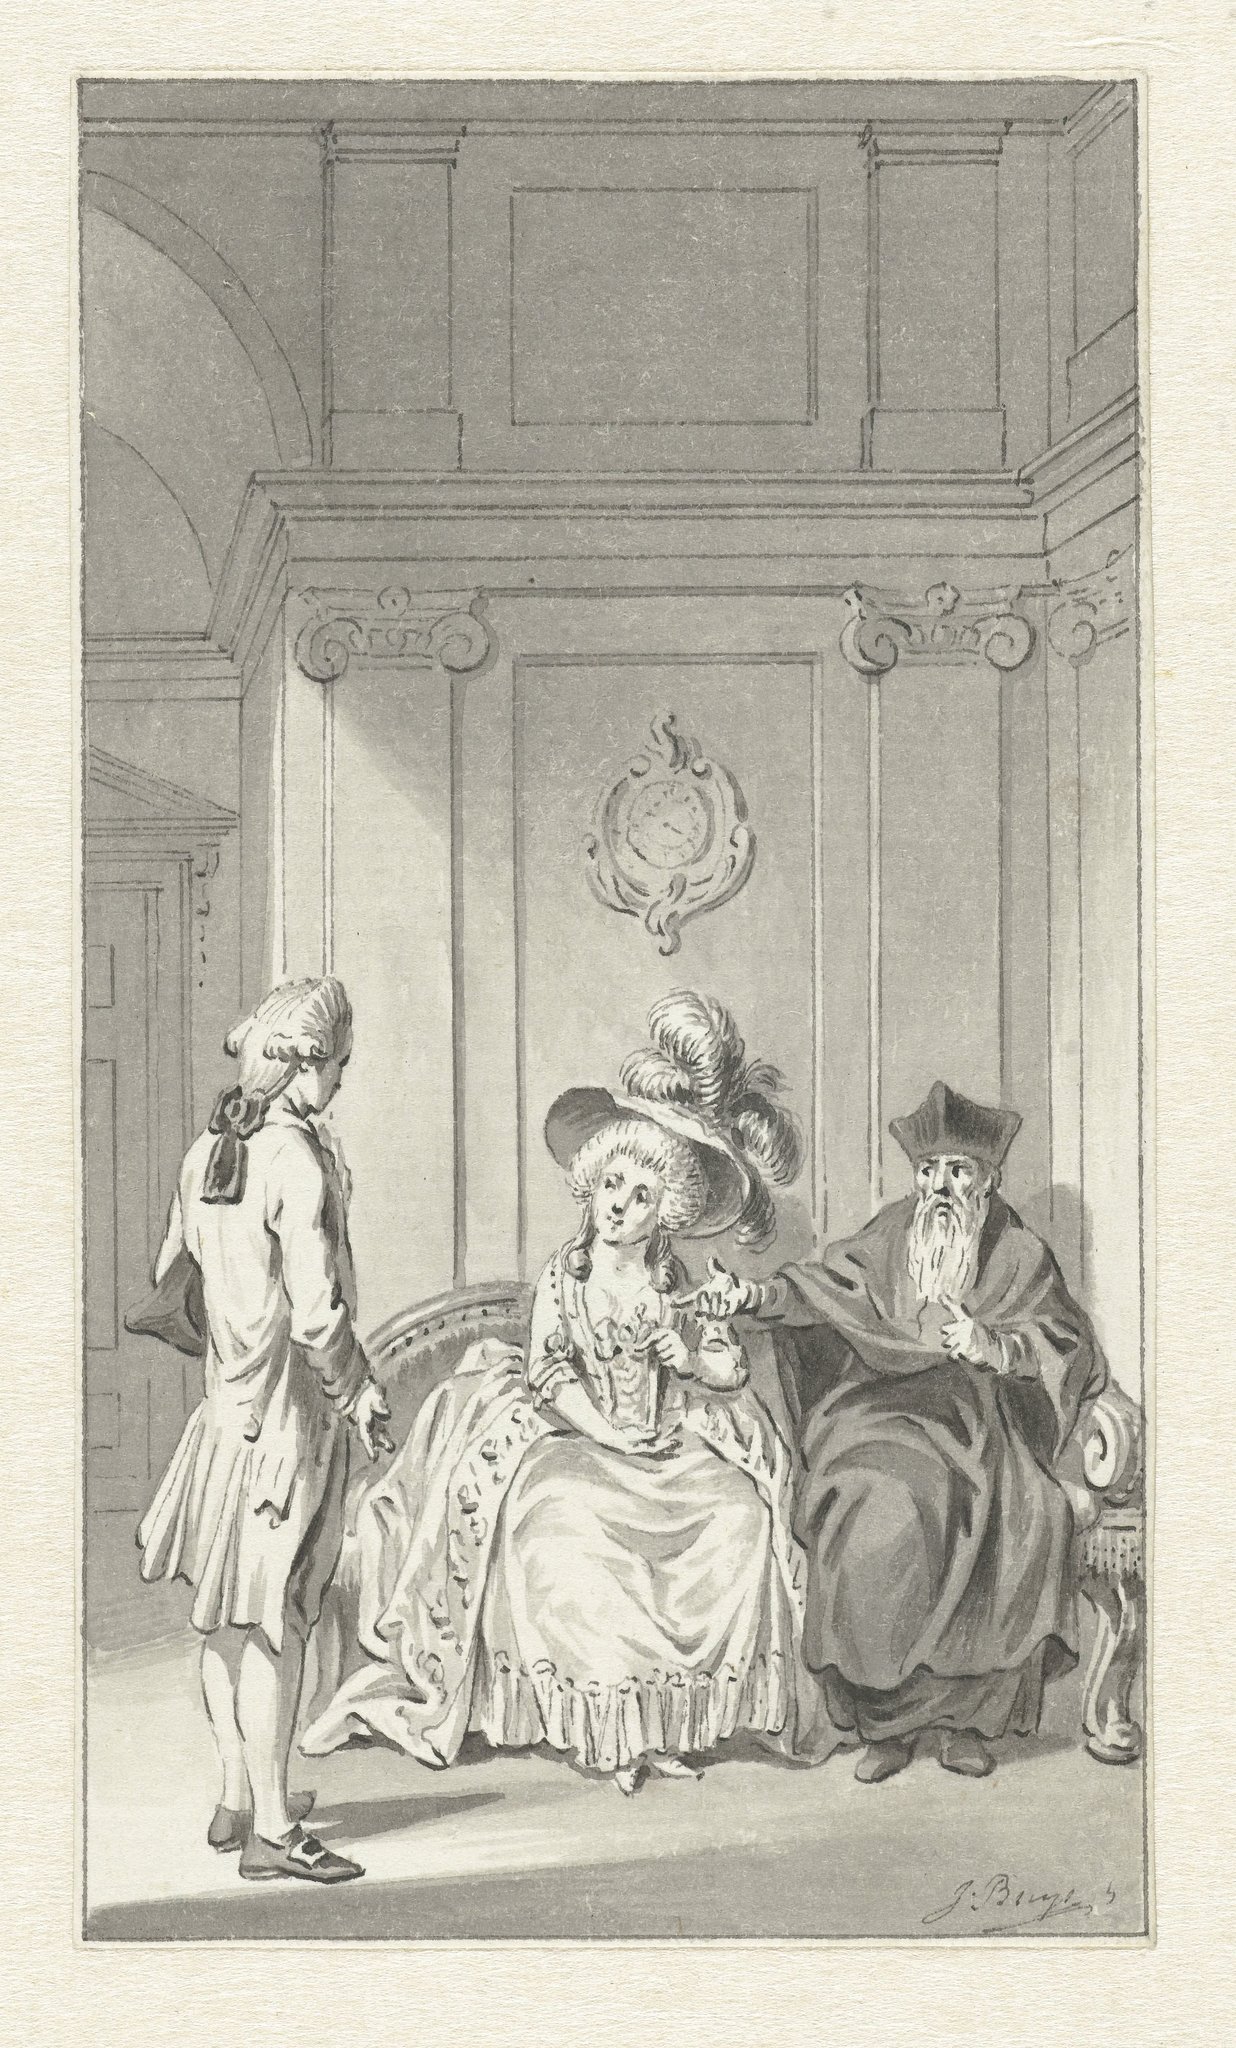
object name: drawing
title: Interieur met geestelijke, dame en jongeman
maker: jacobus buys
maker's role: draughtsman, print maker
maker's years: 1724-1801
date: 1734-1801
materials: ink, paper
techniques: brush, pen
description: Interieur met geestelijke naast een dame zittend; voor hen staat een jongeman.